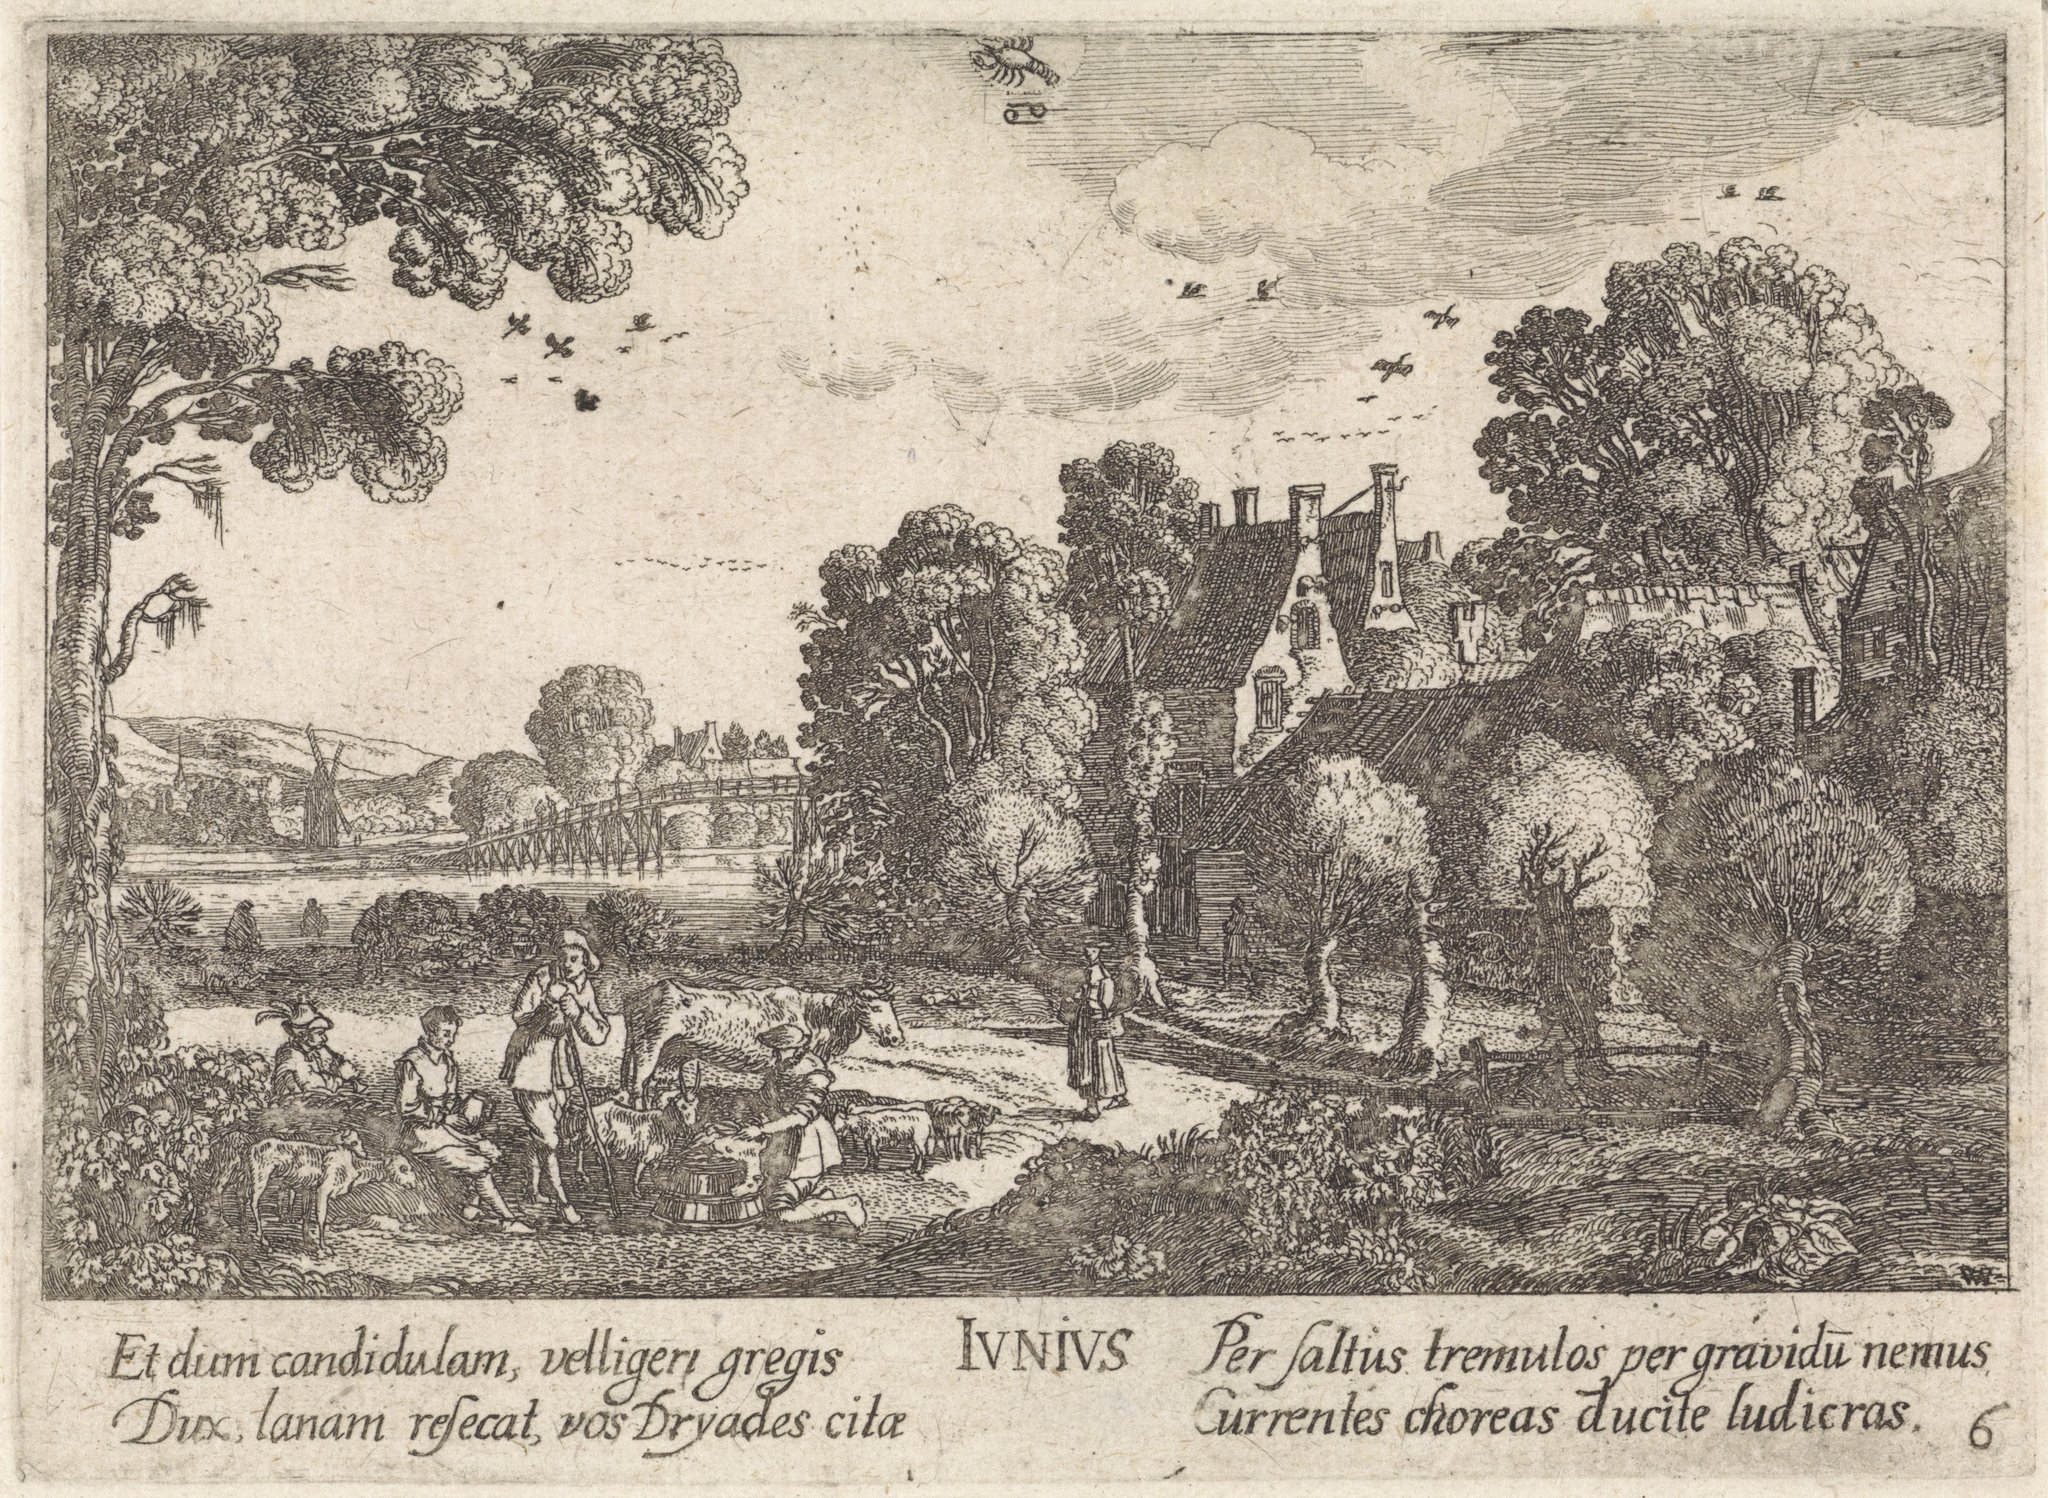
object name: print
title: Ivnivs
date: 1684-1729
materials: paper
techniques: etching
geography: germany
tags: cancer (zodiacal sign of june), landscape symbolizing june, june and its 'labours', herd, flock, abcoude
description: Landschap met herders met hun vee op een veld bij een dorp bij een houten brug; Ouderkerk aan de Amstel naar Abcoude, voorstellende de maand juni. Bovenaan het bij deze maand behorende sterrenbeeld: kreeft. Zesde prent uit een serie van twaalf.